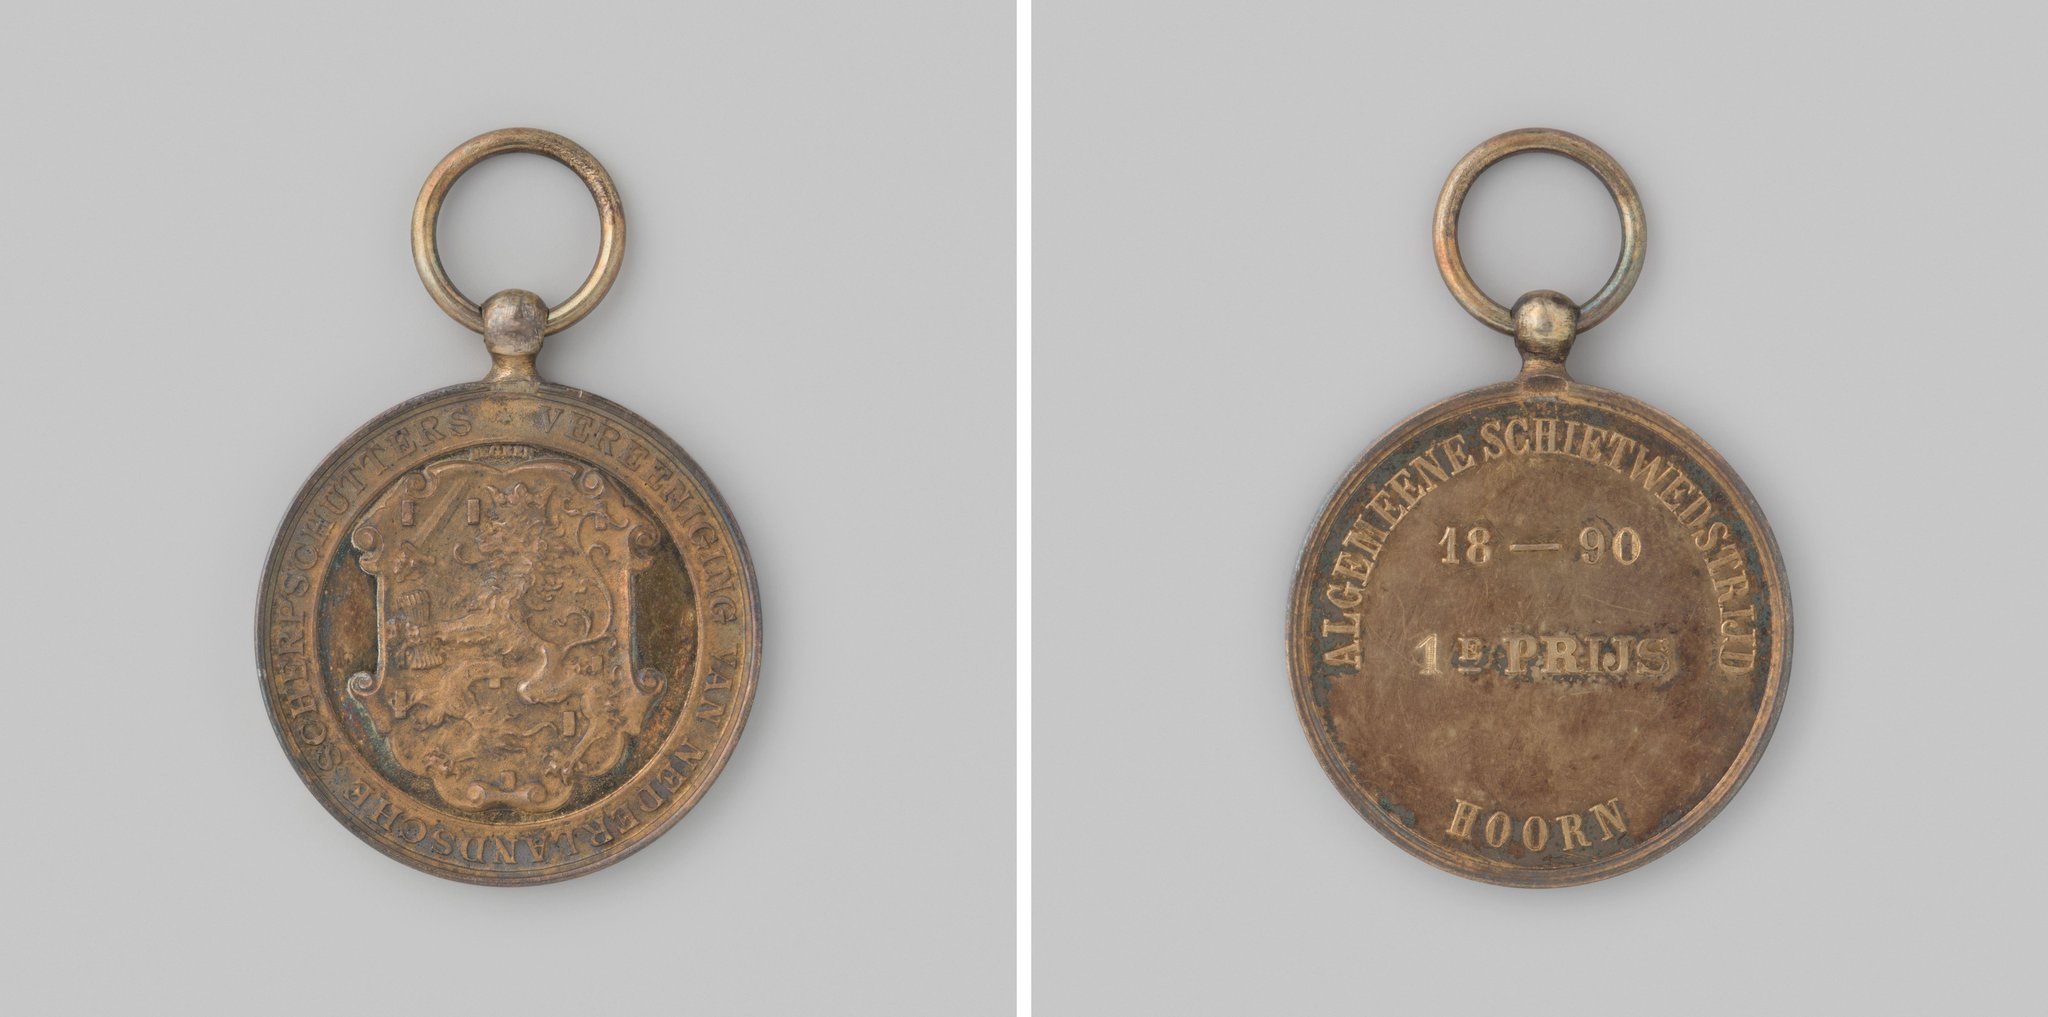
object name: medal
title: Prijspennning van de Vereeniging van Nederlandsche Scherpschutters, individueel vuur, eerste prijs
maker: Anonymous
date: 1890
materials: silver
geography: hoorn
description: Verguld zilveren penning met oog en ring van de Vereeniging van Nederlandsche Scherpschutters, behaald door de detachementen van het 1e en 2e bataljon regiment Schutterij te Amsterdam, 1890. Schietwedstrijd op 25 augustus 1890 in Hoorn. Voorzijde: het Nederlandse wapen in renaissancestijl. Omschrift: VEREENIGING VAN NEDERLANDSCHE SCHERPSCHUTTERS. Keerzijde: ALGEMENE SCHIETWEDSTRIJD HOORN. In het veld gegraveerd: 18-90 / 1e PRIJS.